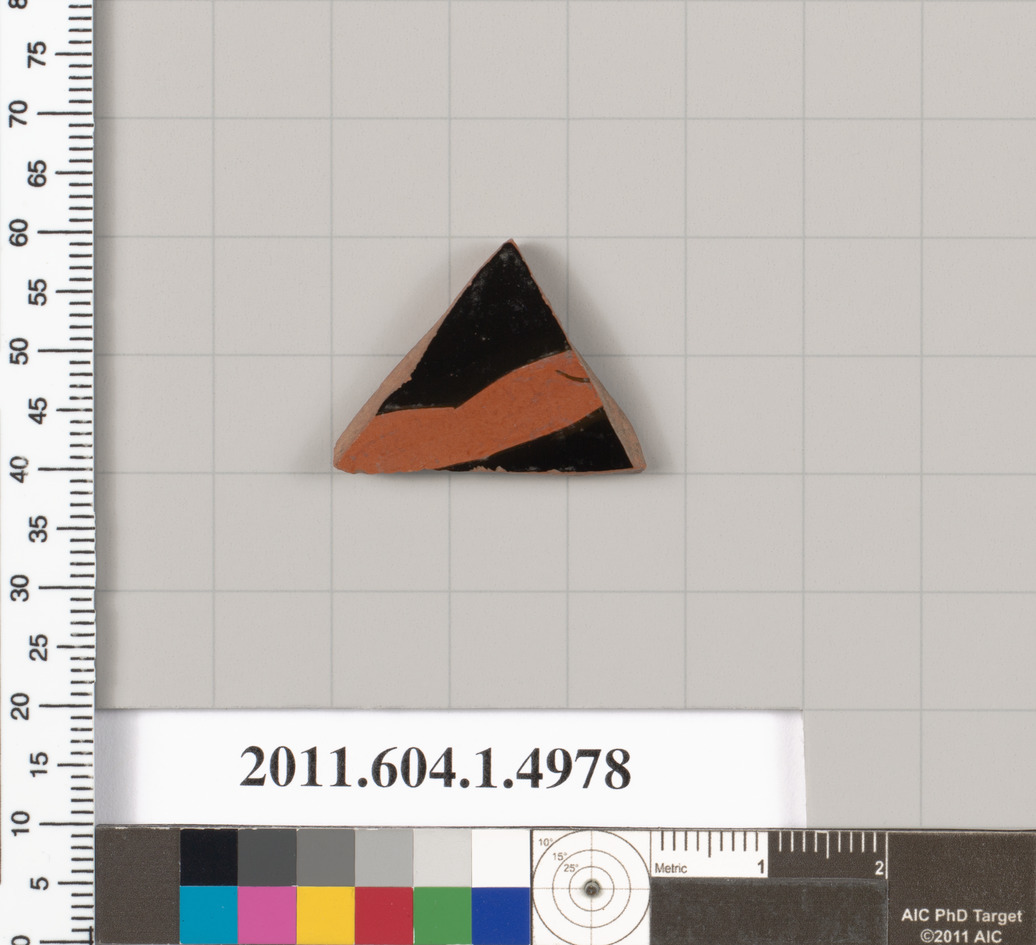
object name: kylix fragment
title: Terracotta fragment of a kylix (drinking cup)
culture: greek, attic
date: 500-480 BCE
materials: terracotta